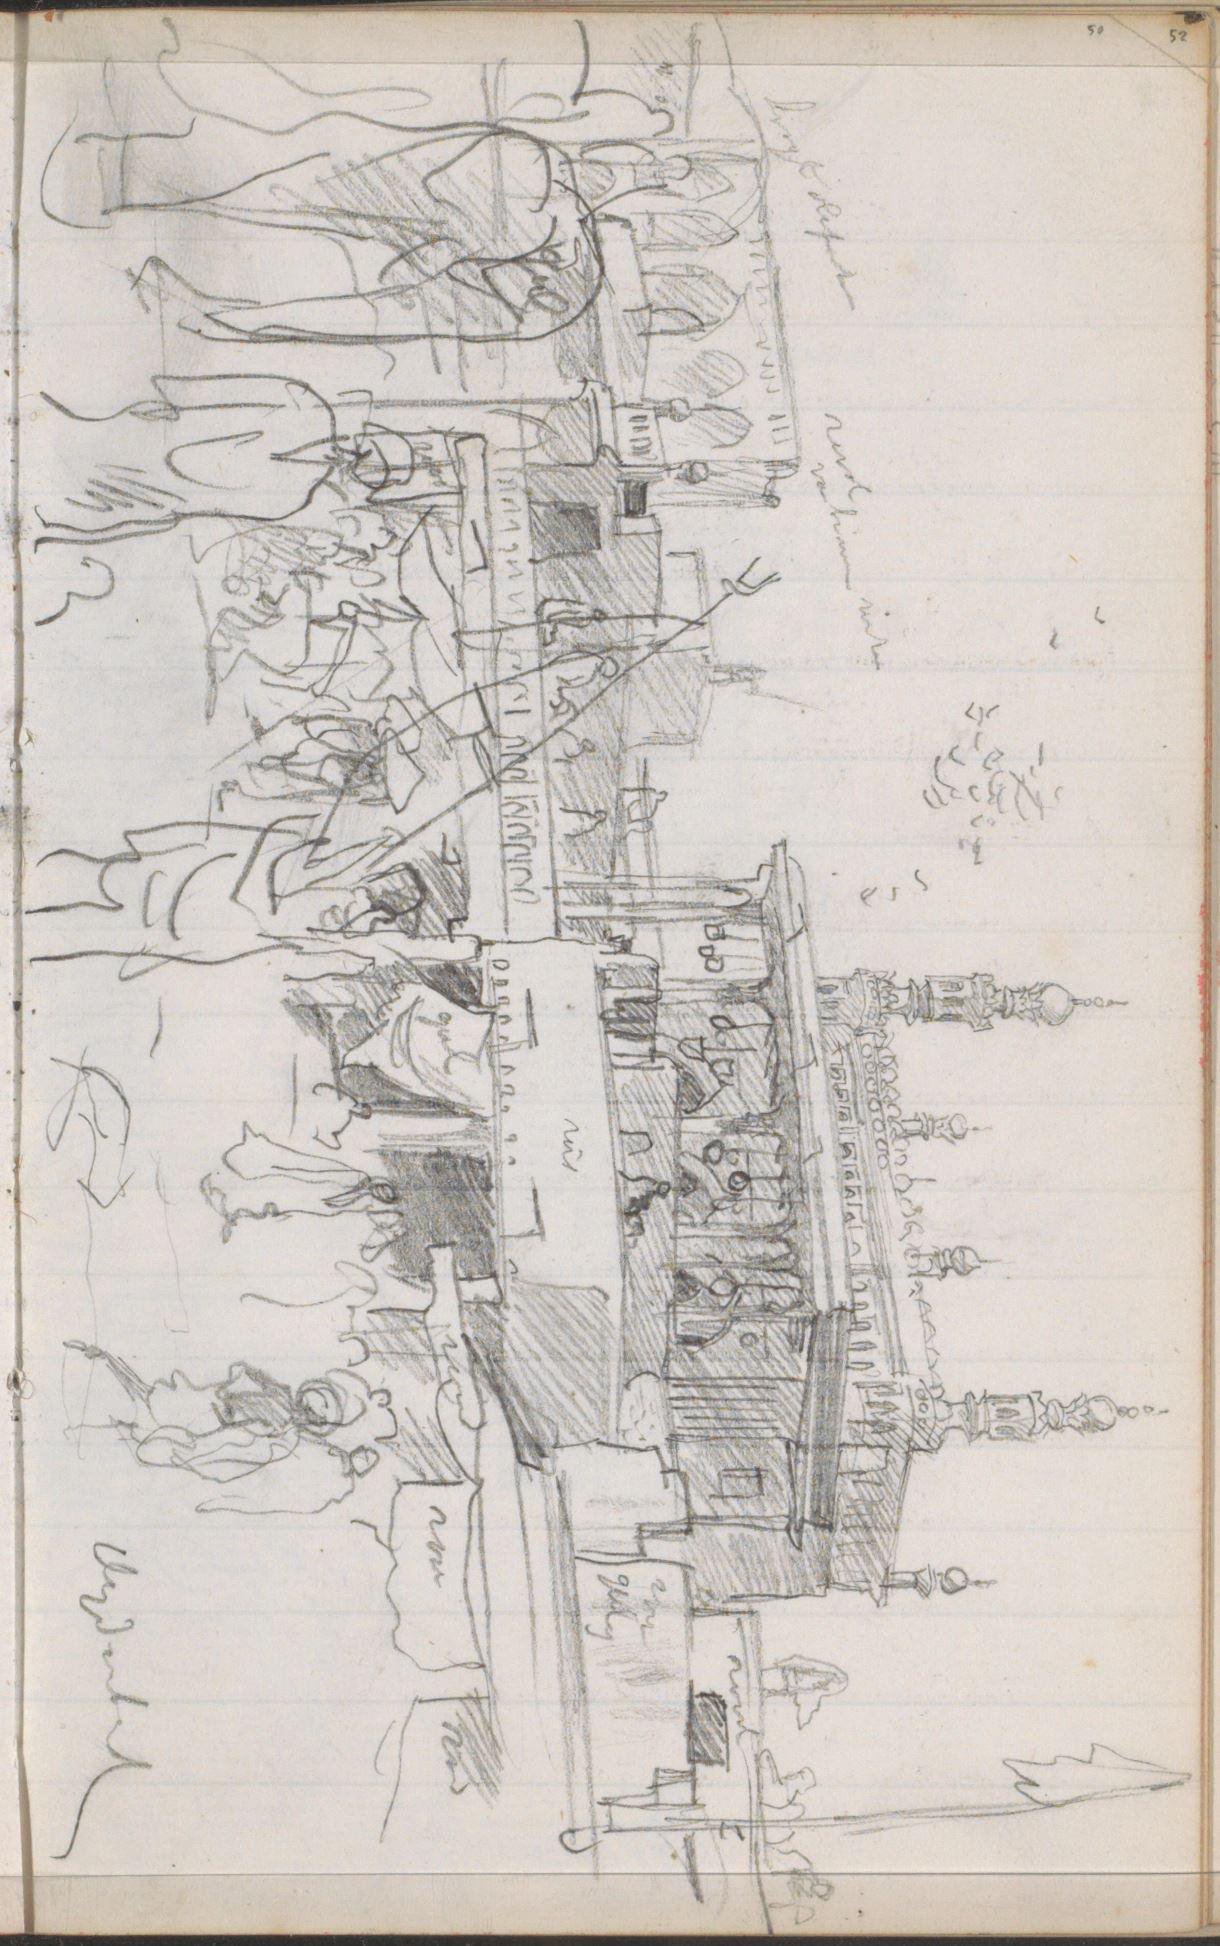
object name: sketchbook leaf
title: Straat in Hyderabad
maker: marius bauer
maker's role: draughtsman, print maker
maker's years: 1867-1932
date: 1897-1898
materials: pencil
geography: hyderabad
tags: spire (of tower on house or building), architecture, trunked animals: elephant, street (+ city(-scape) with figures, staffage)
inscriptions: annotation: ‘Hyderabad’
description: Aan de straat ligt een gebouw met gedecoreerde torens. Op de straat lopen figuren en een olifant. Pagina 50 uit een schetsboek met 62 bladen.